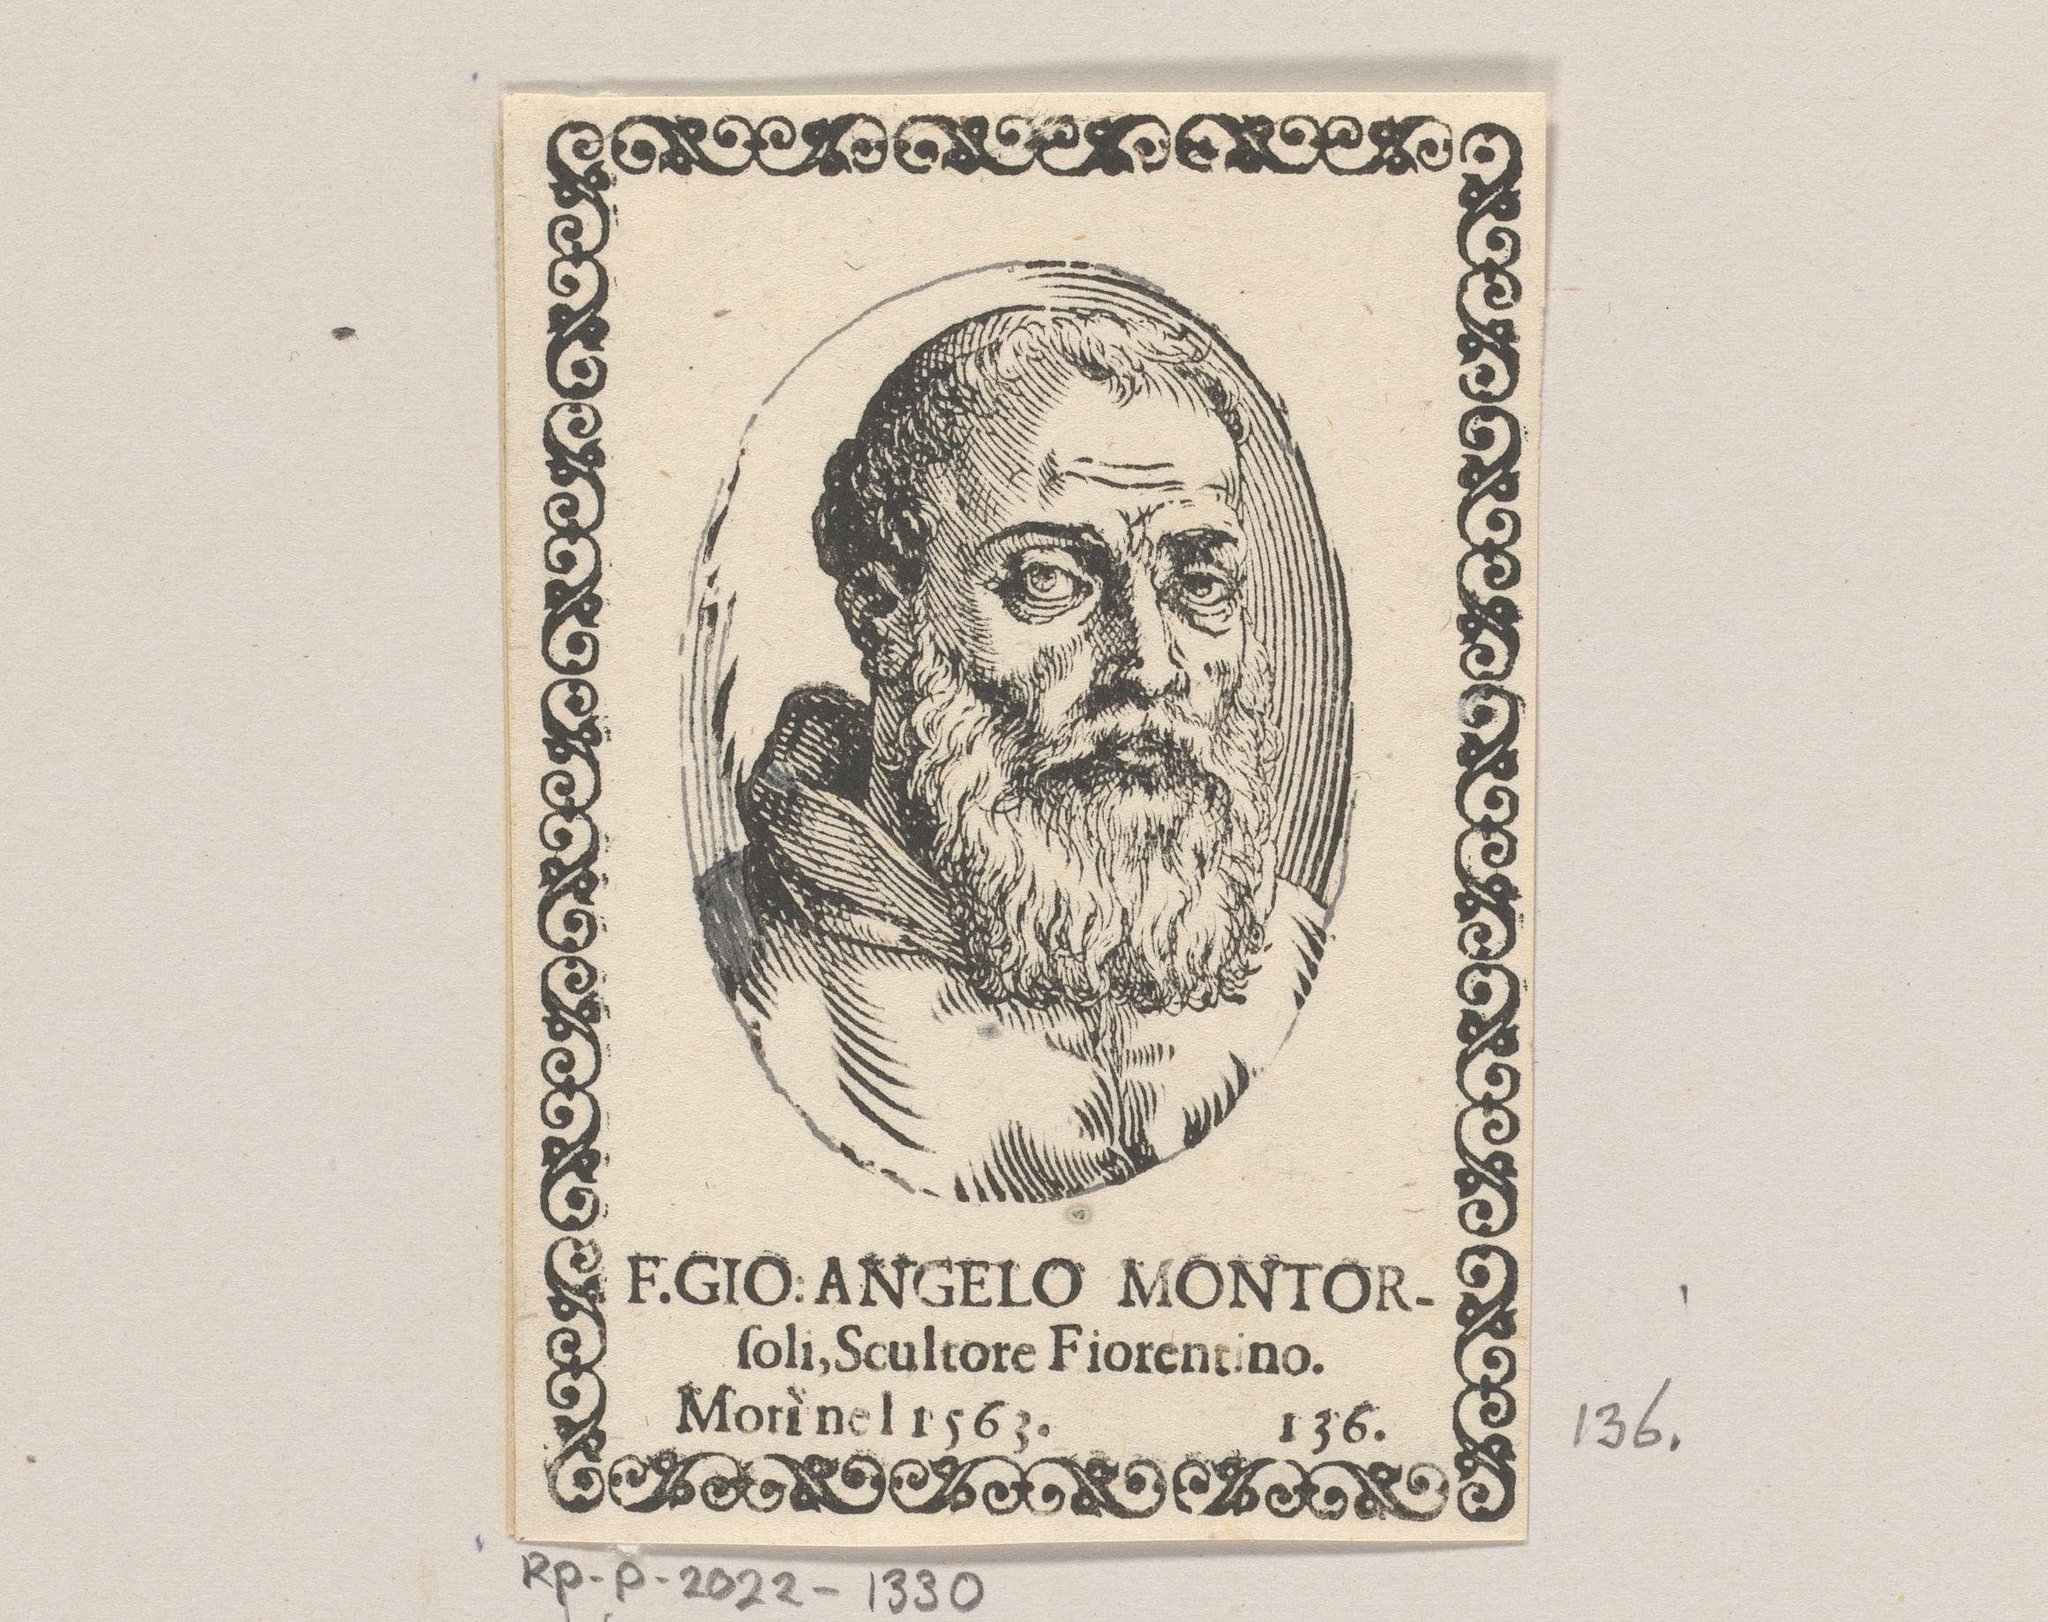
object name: book illustration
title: Portret van Giovanni Angelo Montorsoli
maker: Anonymous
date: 1568-1650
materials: paper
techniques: letterpress printing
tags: sculptor, giovanni angelo montorsoli, portrait, self-portrait of sculptor, historical persons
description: Prent komt vermoedelijk uit een editie van Vasari's 'Vite'. Vergelijkbare prenten zijn bijvoorbeeld gebruikt in de edities uit 1568 en 1647.